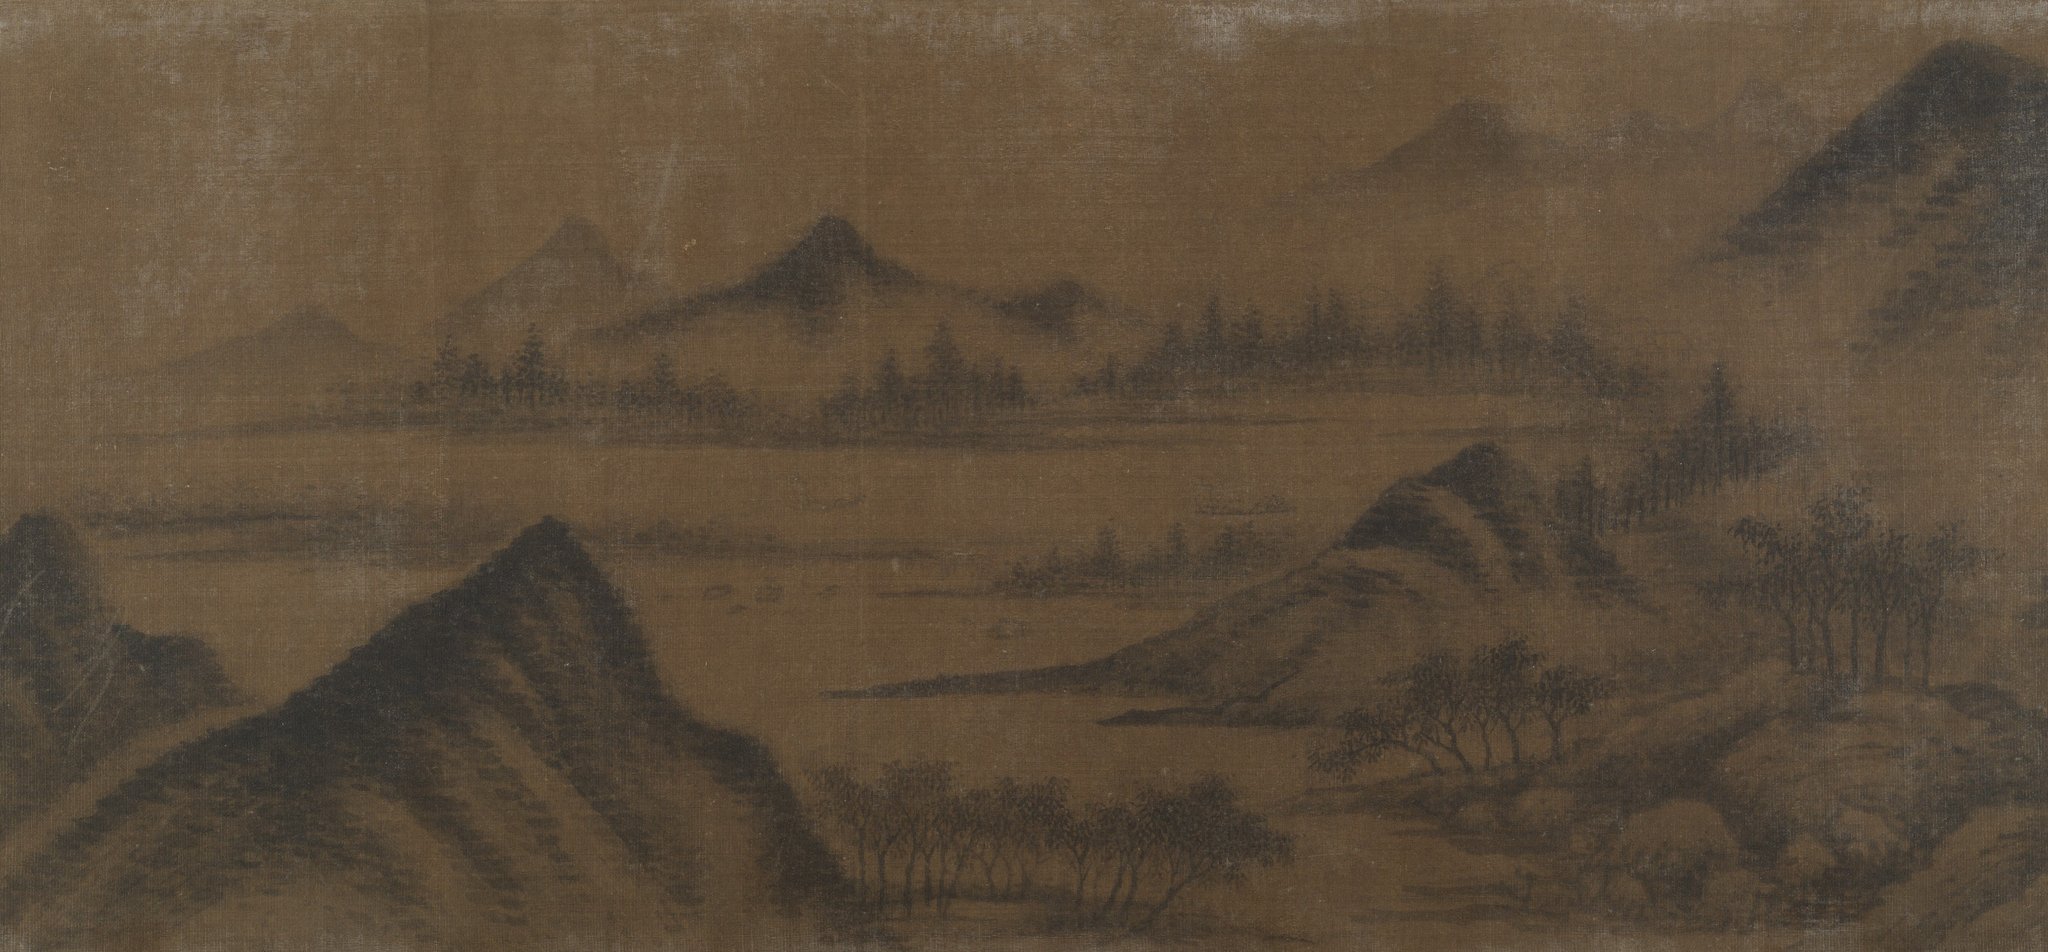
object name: handscroll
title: Mountain Landscape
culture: chinese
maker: unidentified artist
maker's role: artist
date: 1644-1911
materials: ink, silk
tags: mountains,landscapes